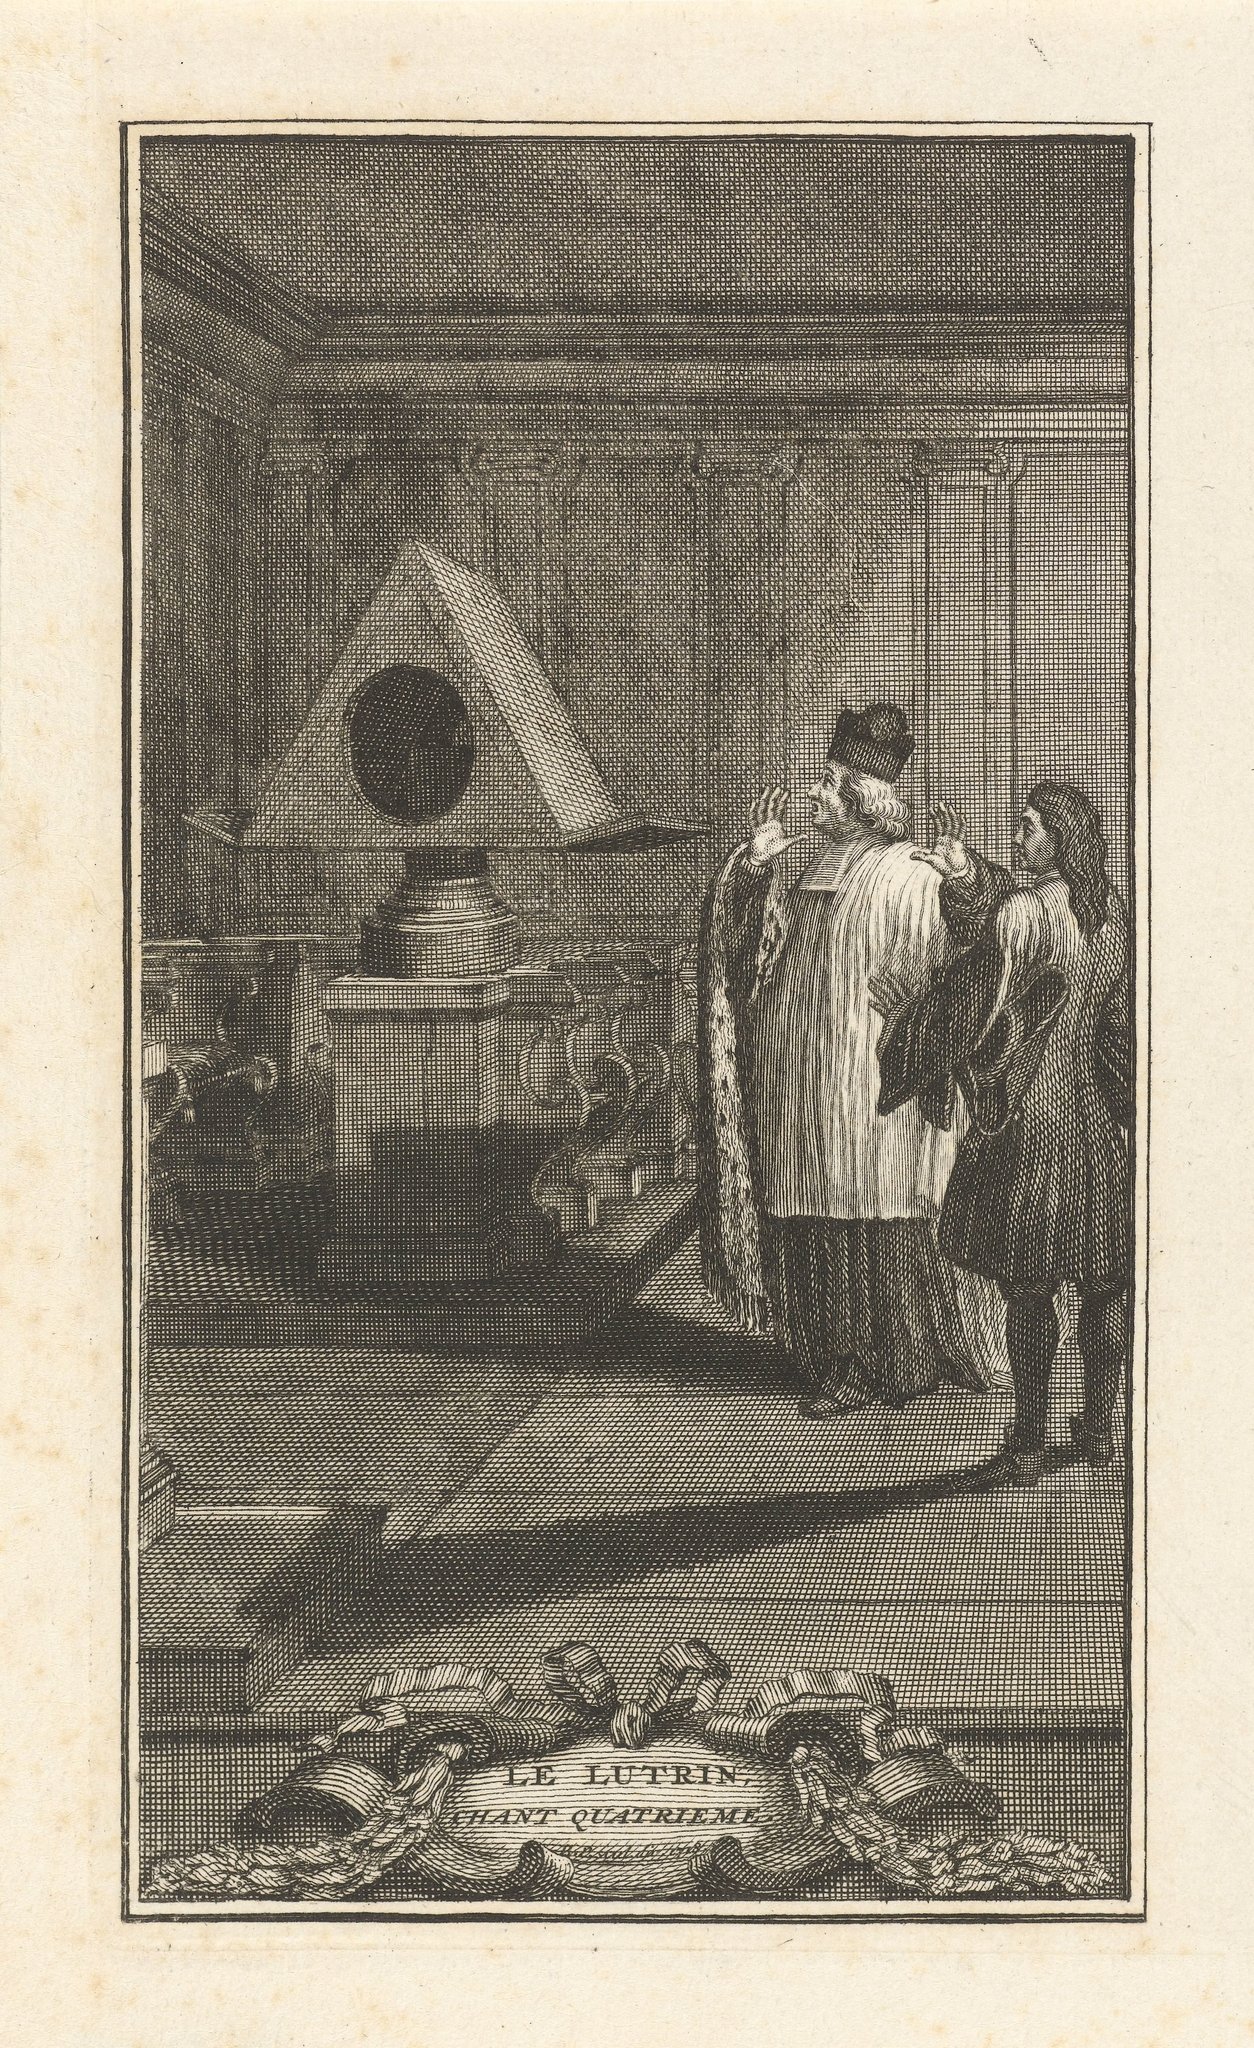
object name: print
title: Priester ontdekt lessenaar (kleine variant)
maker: bernard picart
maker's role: draughtsman, print maker, publisher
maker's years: 1673-1733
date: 1718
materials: paper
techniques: engraving, etching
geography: amsterdam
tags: lectern, hierarchy of jurisdiction ~ roman catholic church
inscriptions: collector's mark: Lugt 2228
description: Prent ook gebruikt als illustratie in: Boileau, Nicolas. Oeuvres de Nicolas Boileau Despréaux. Den Haag: Isaac Vaillant, Pierre Gosse en Pieter de Hondt, 1722.